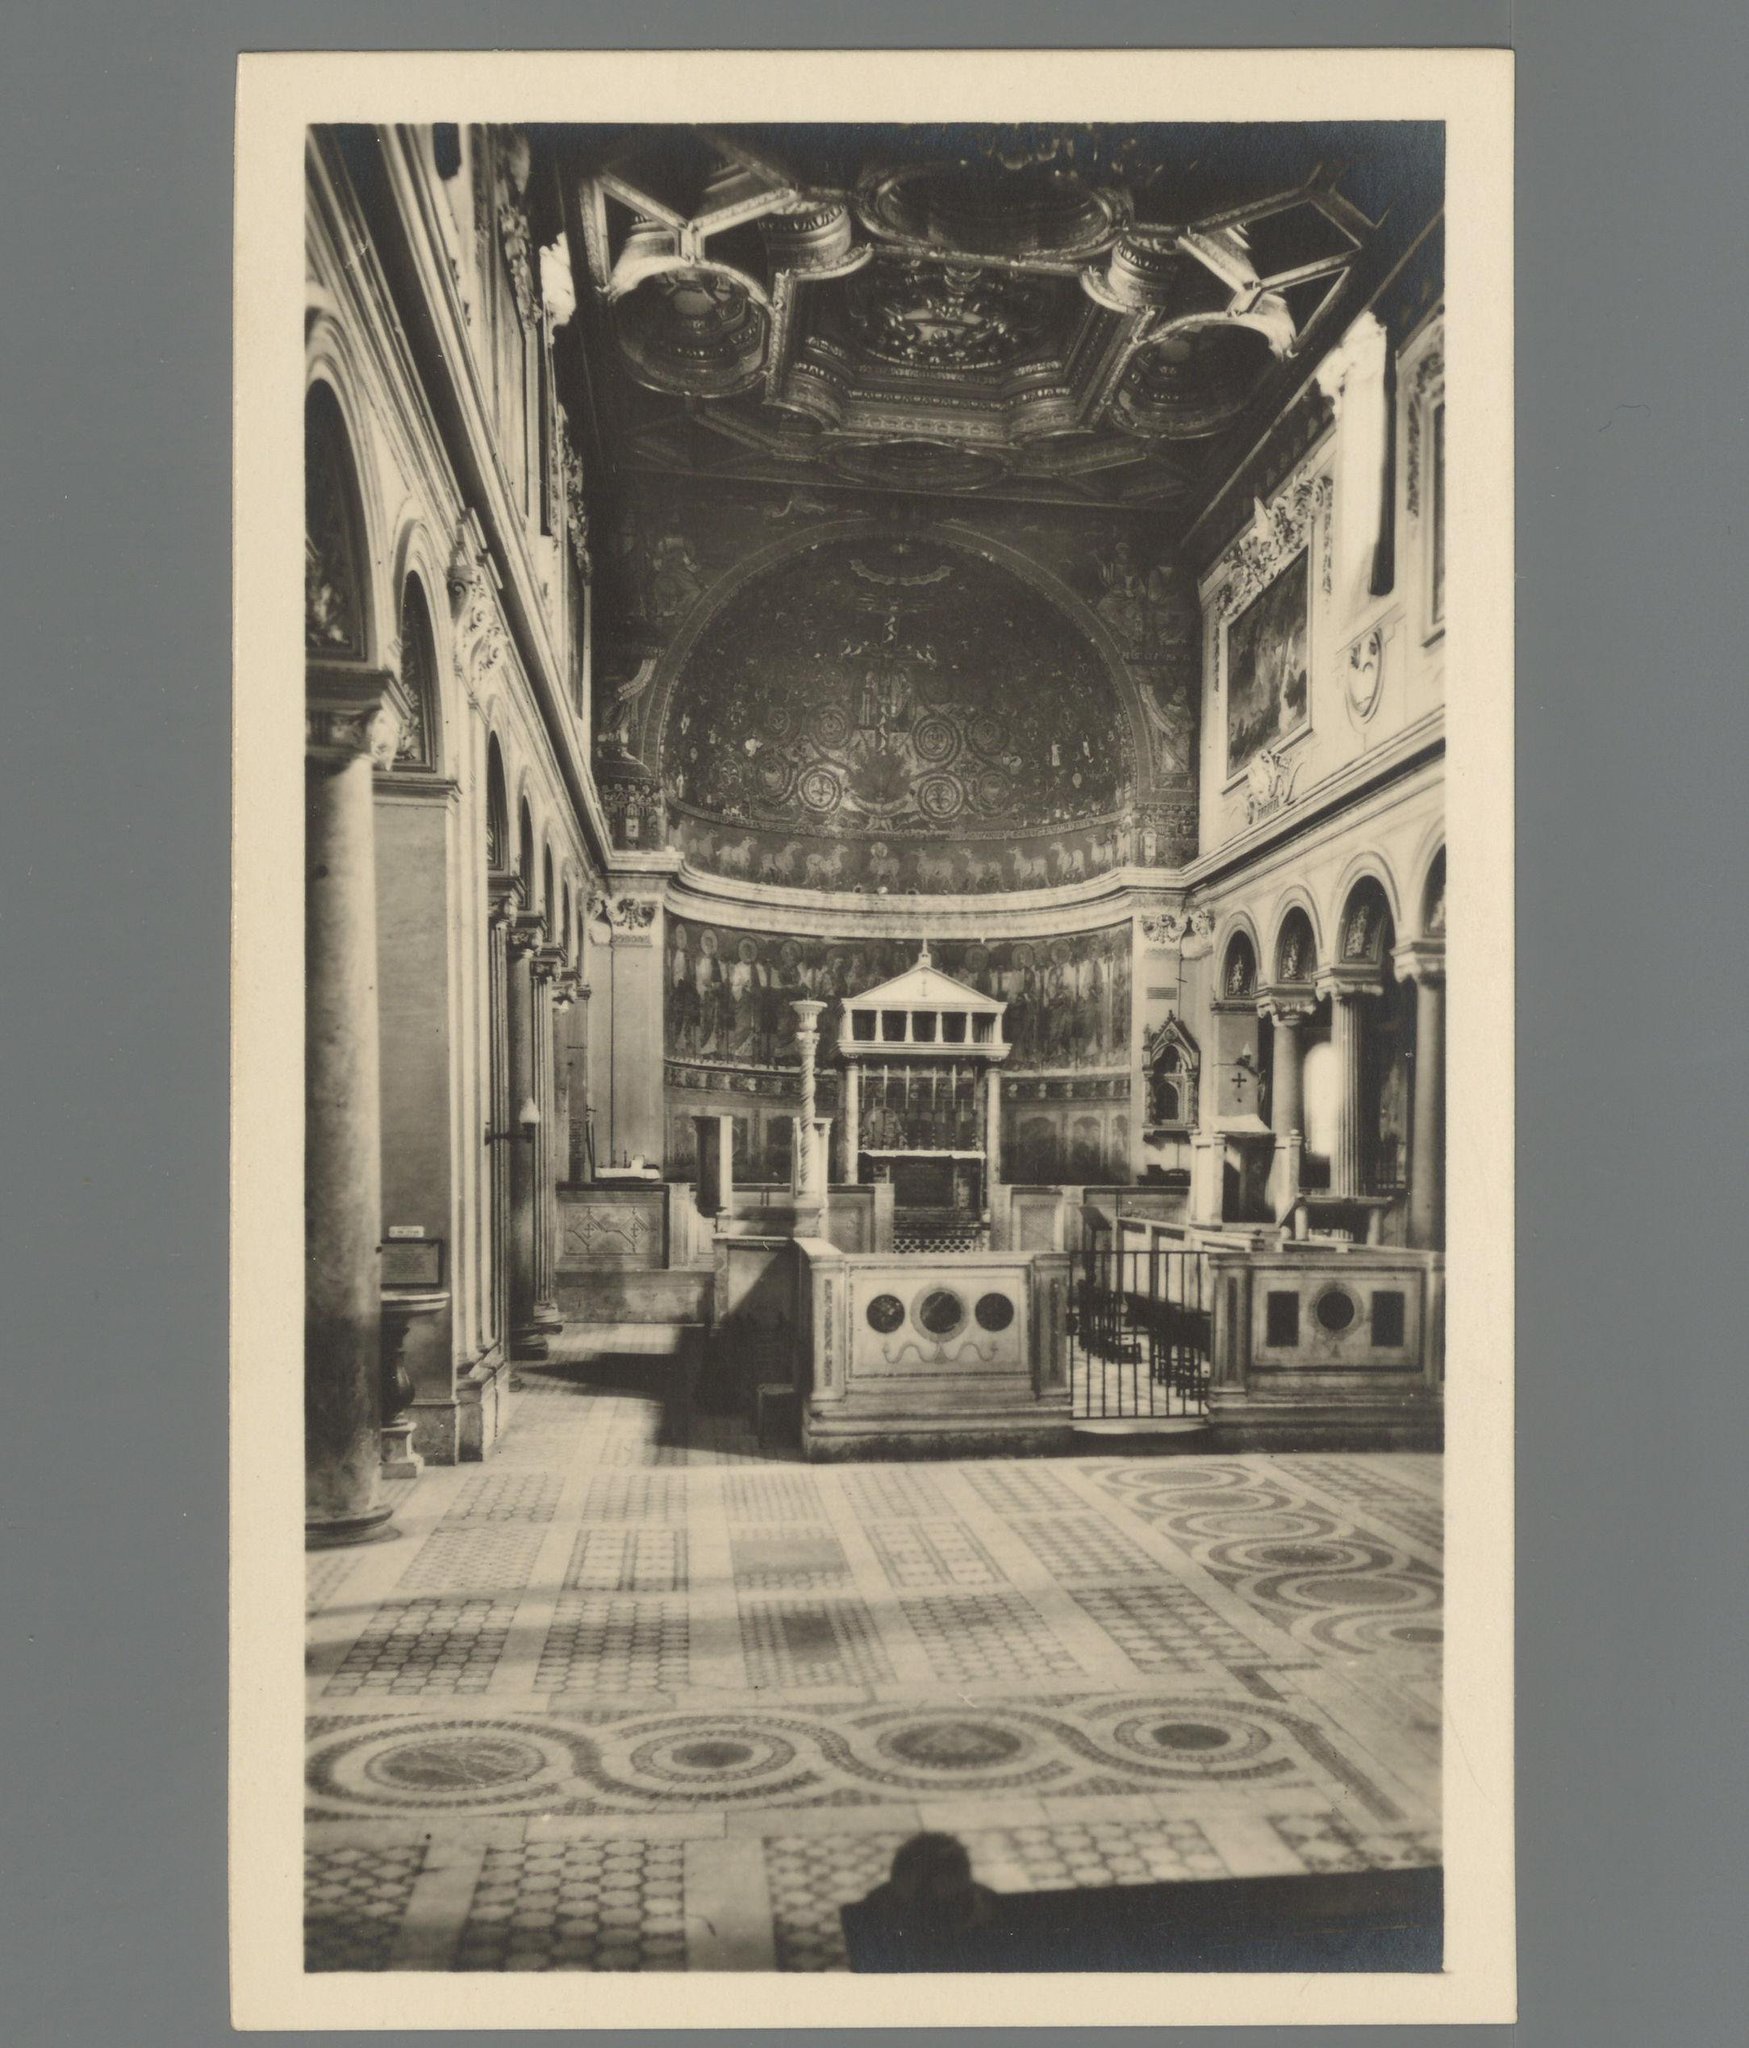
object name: ansichtkaart, prentbriefkaart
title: Roma. Interno della Chiesa di S. Clemente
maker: Anonymous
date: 1931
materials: photographic support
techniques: photography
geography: rome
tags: interior of church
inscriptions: date